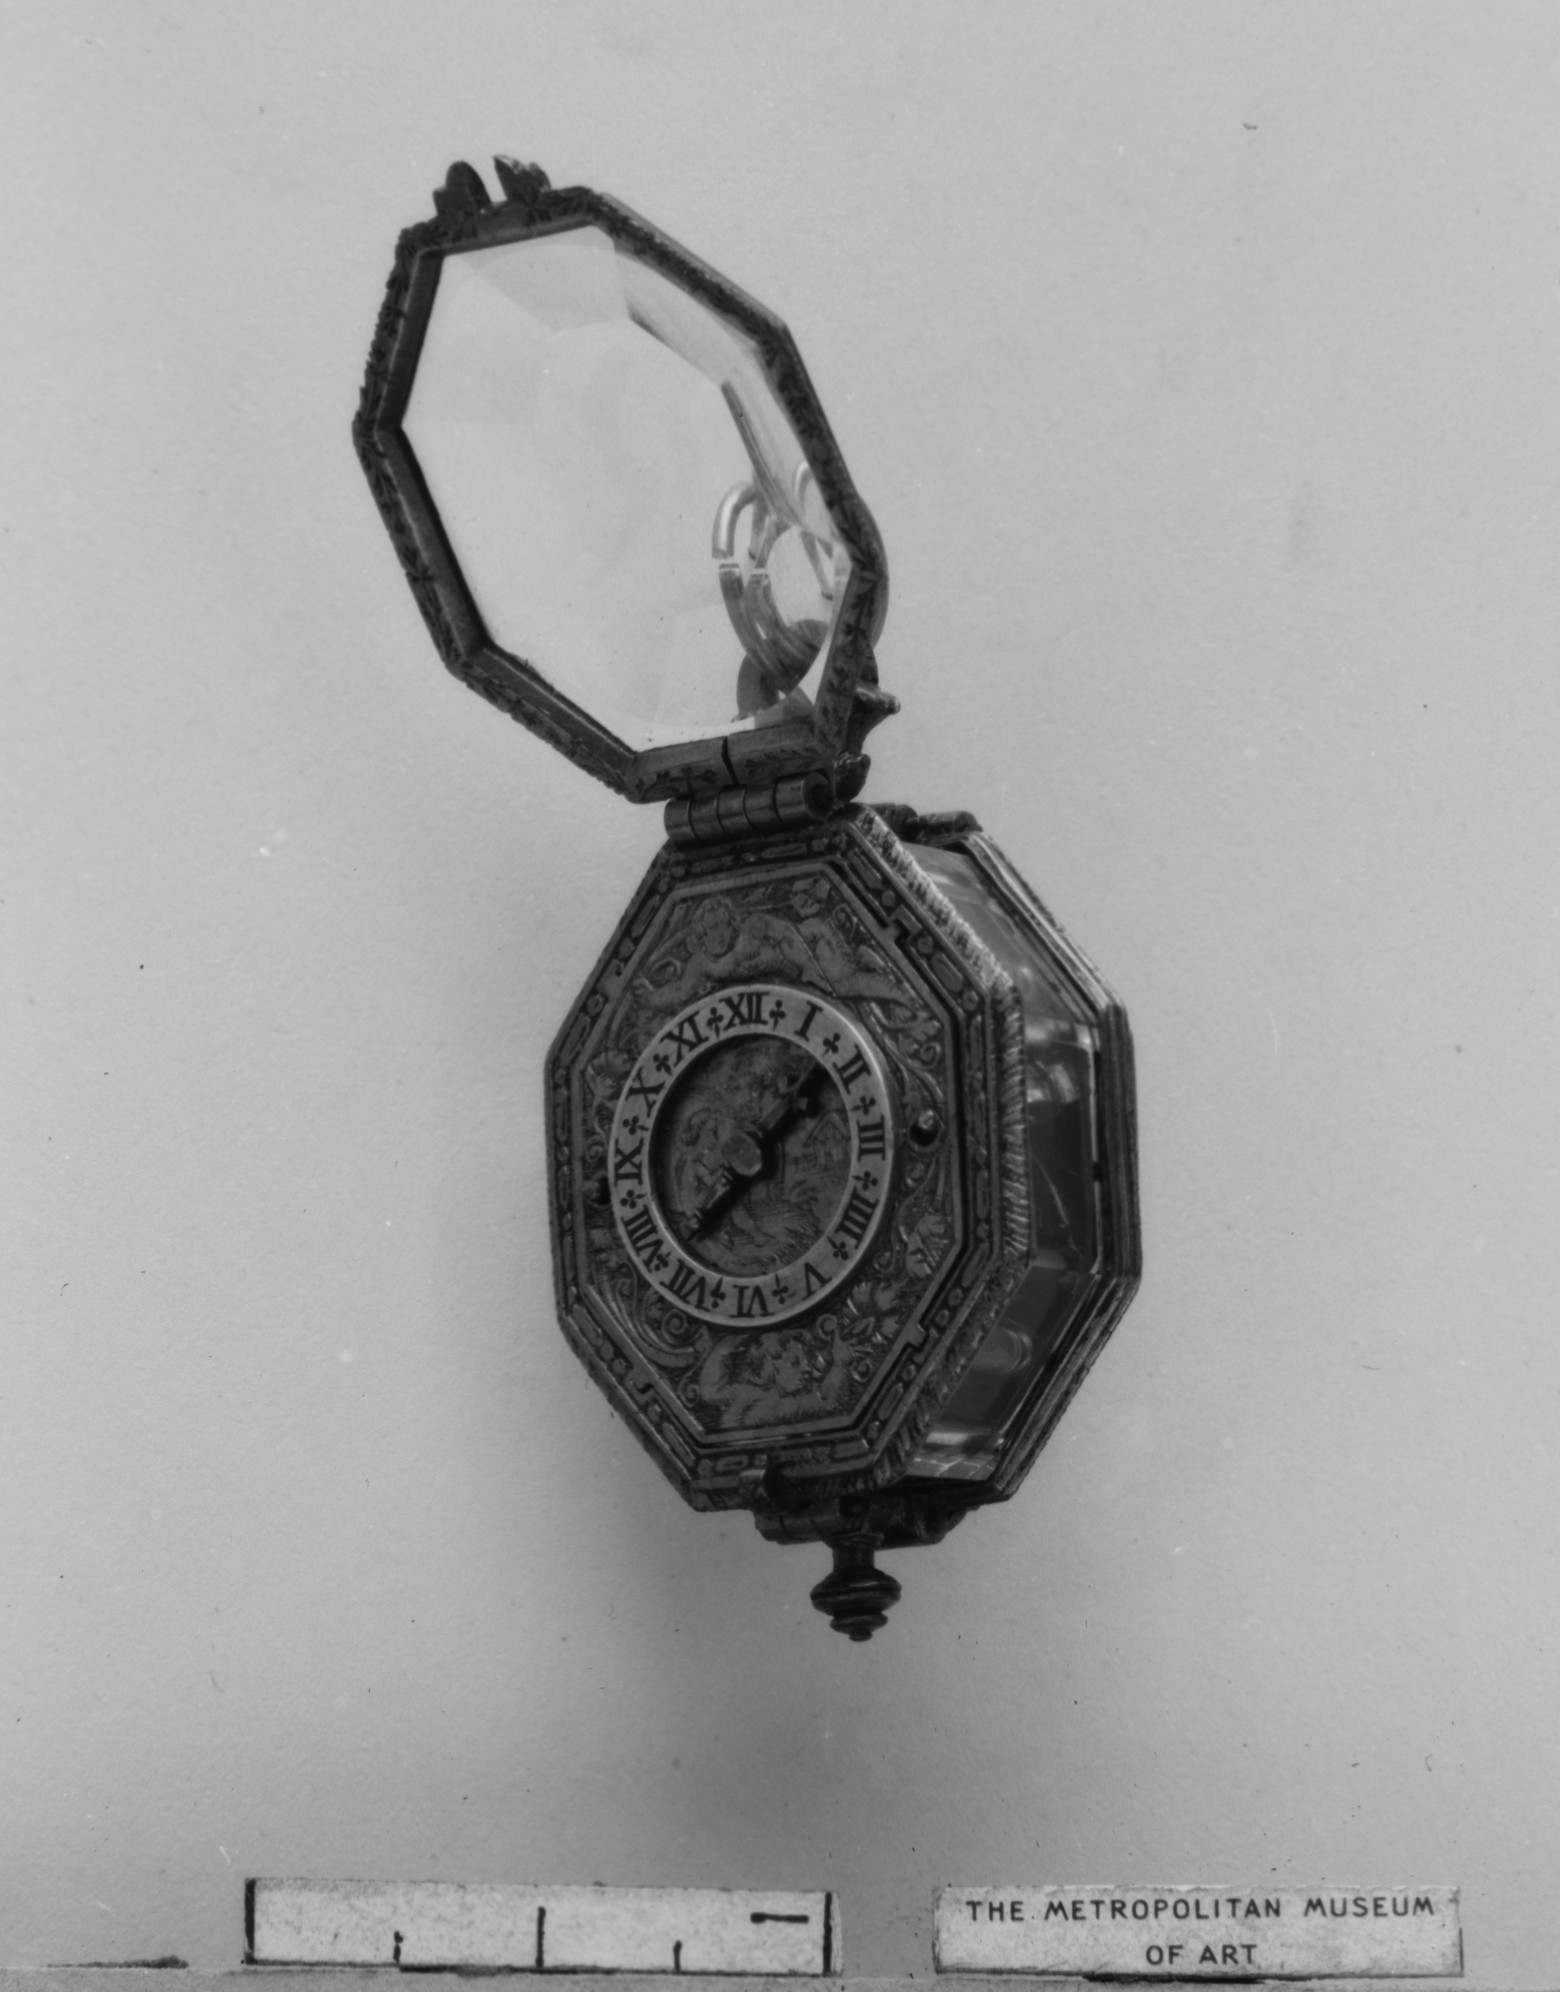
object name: watch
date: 1650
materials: gilt, metal, quartz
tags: male nudes